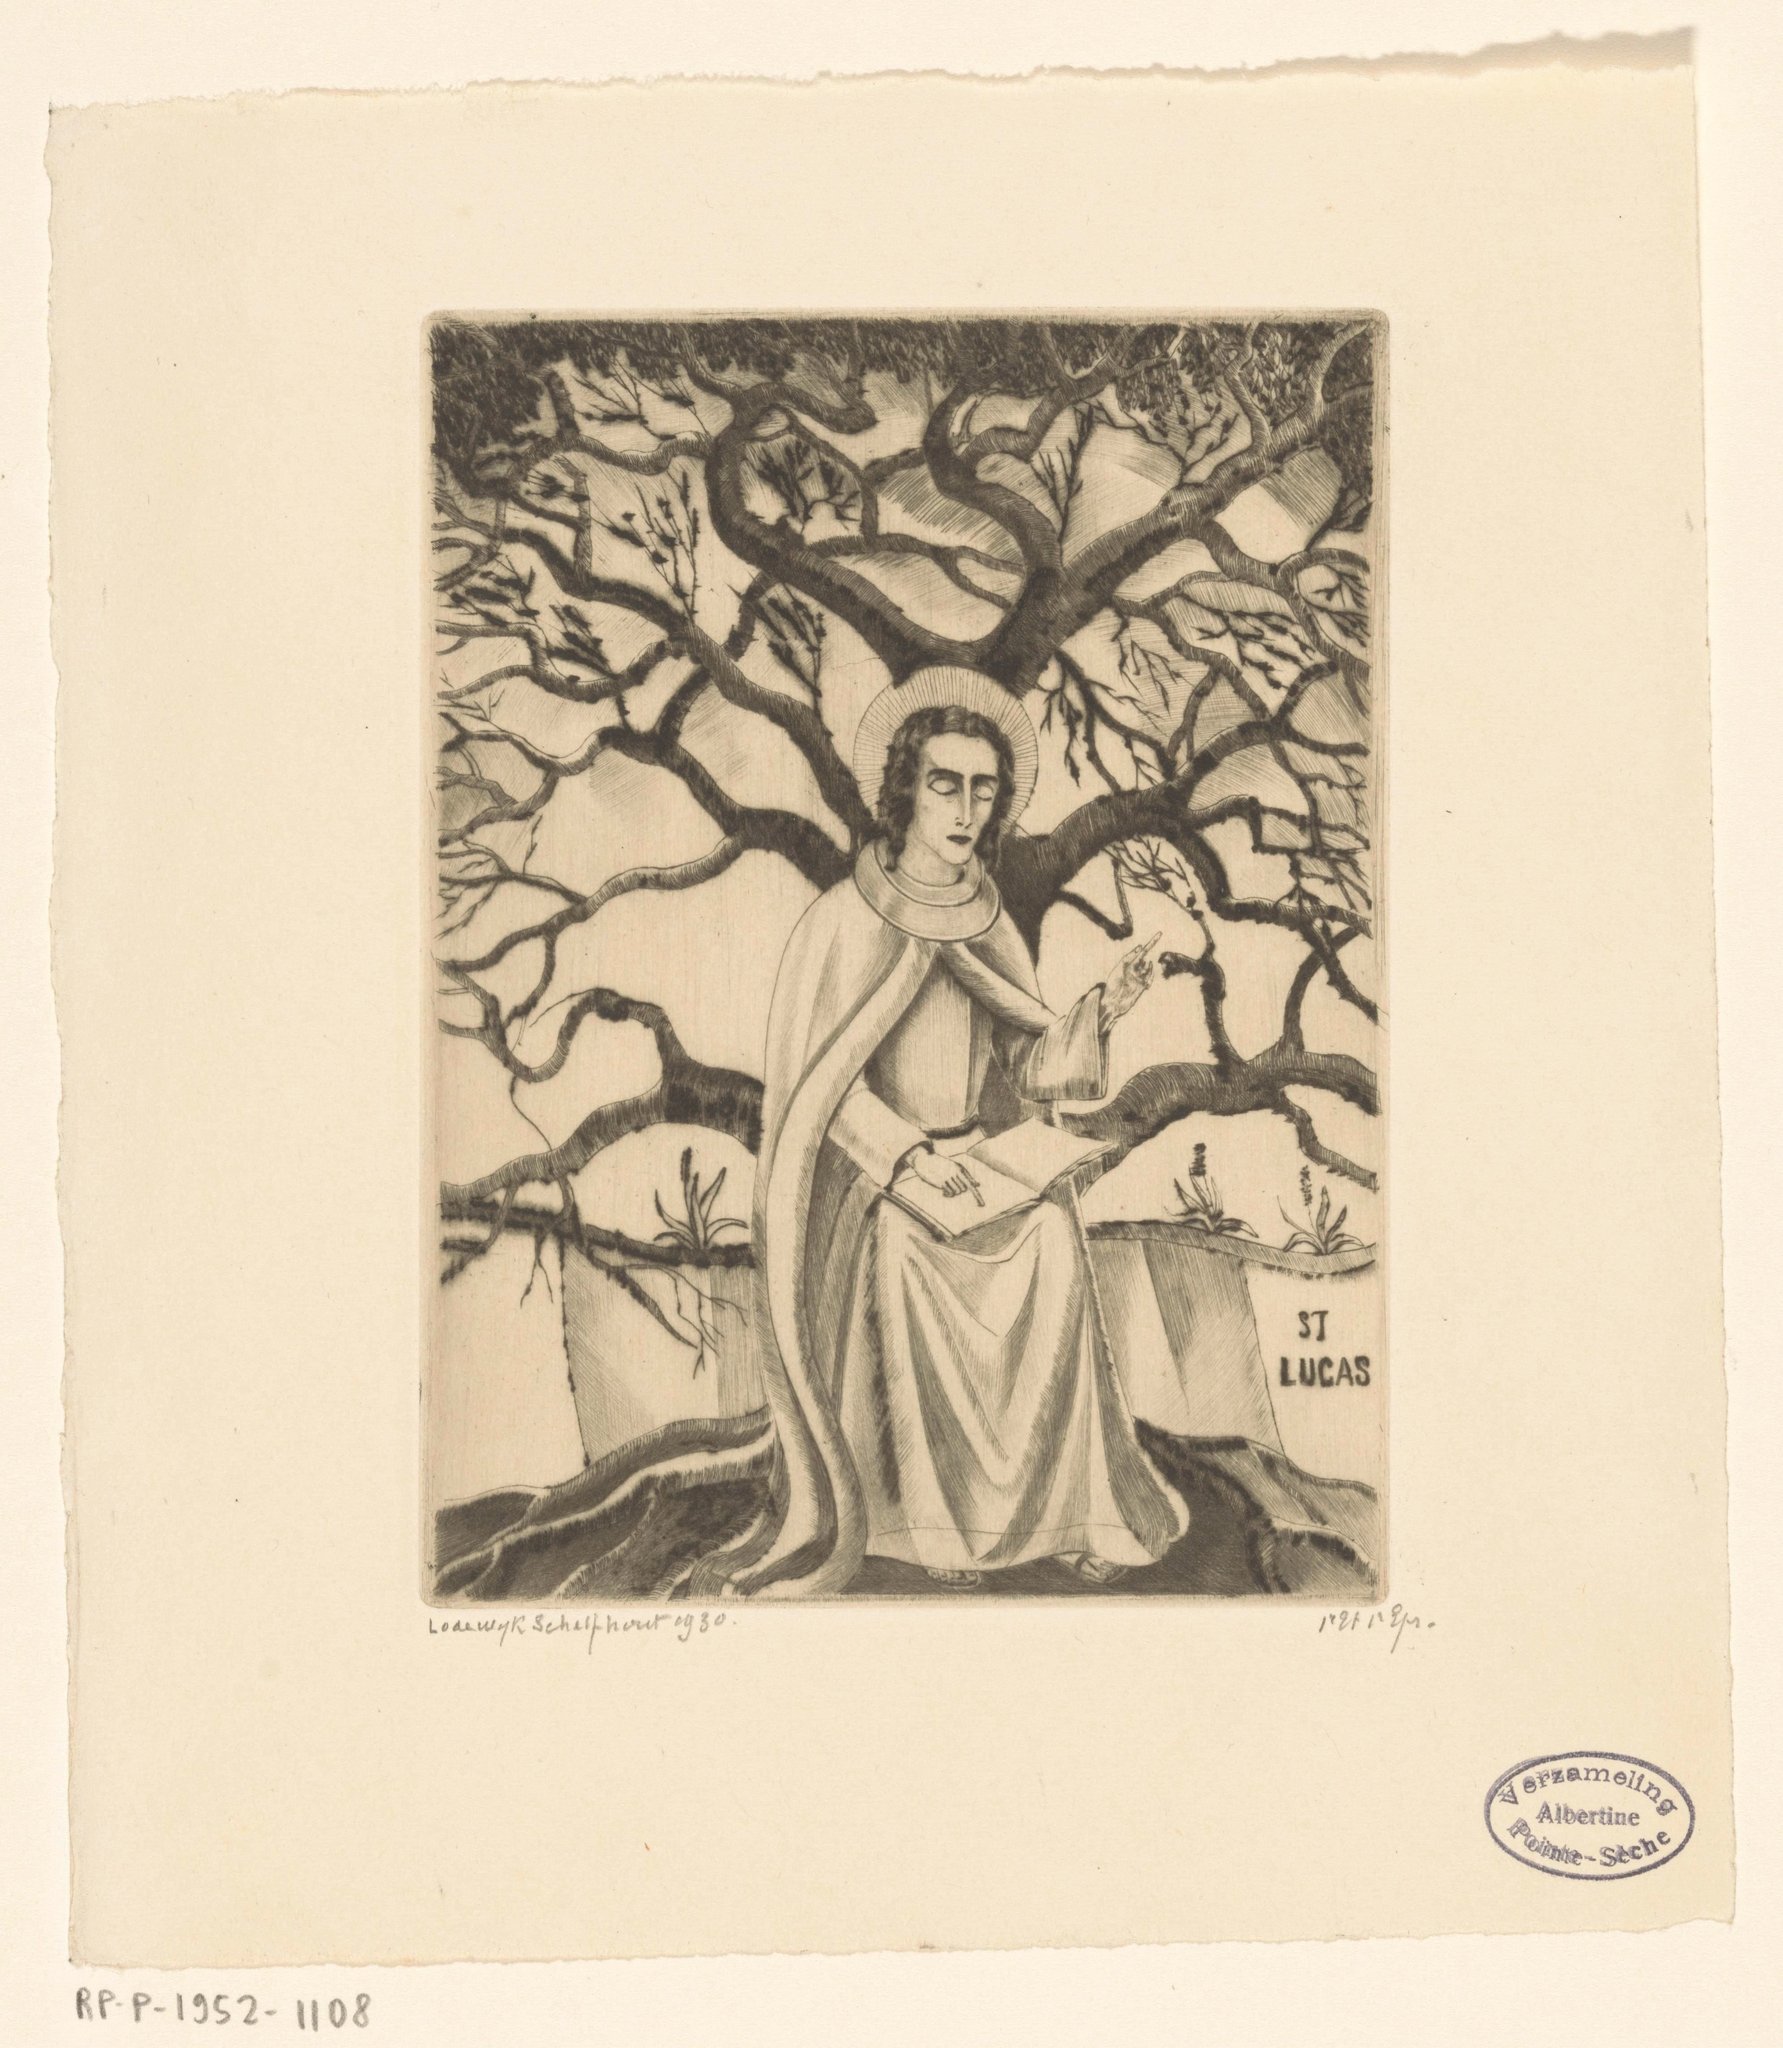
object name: print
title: St. Lucas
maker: lodewijk schelfhout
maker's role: draughtsman, print maker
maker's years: 1881-1943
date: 1930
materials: paper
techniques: drypoint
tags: trees, luke the evangelist; possible attributes: book, (winged) ox, portrait of the virgin, surgical instruments, painter's utensils, scroll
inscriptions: collector's mark: Lugt 5i, collector's mark: Lugt 2228, collector's mark: Lugt 2760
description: De evangelist Lucas, zittend bij een boom en lezend uit een boek, waarschijnlijk zijn eigen evangelie.